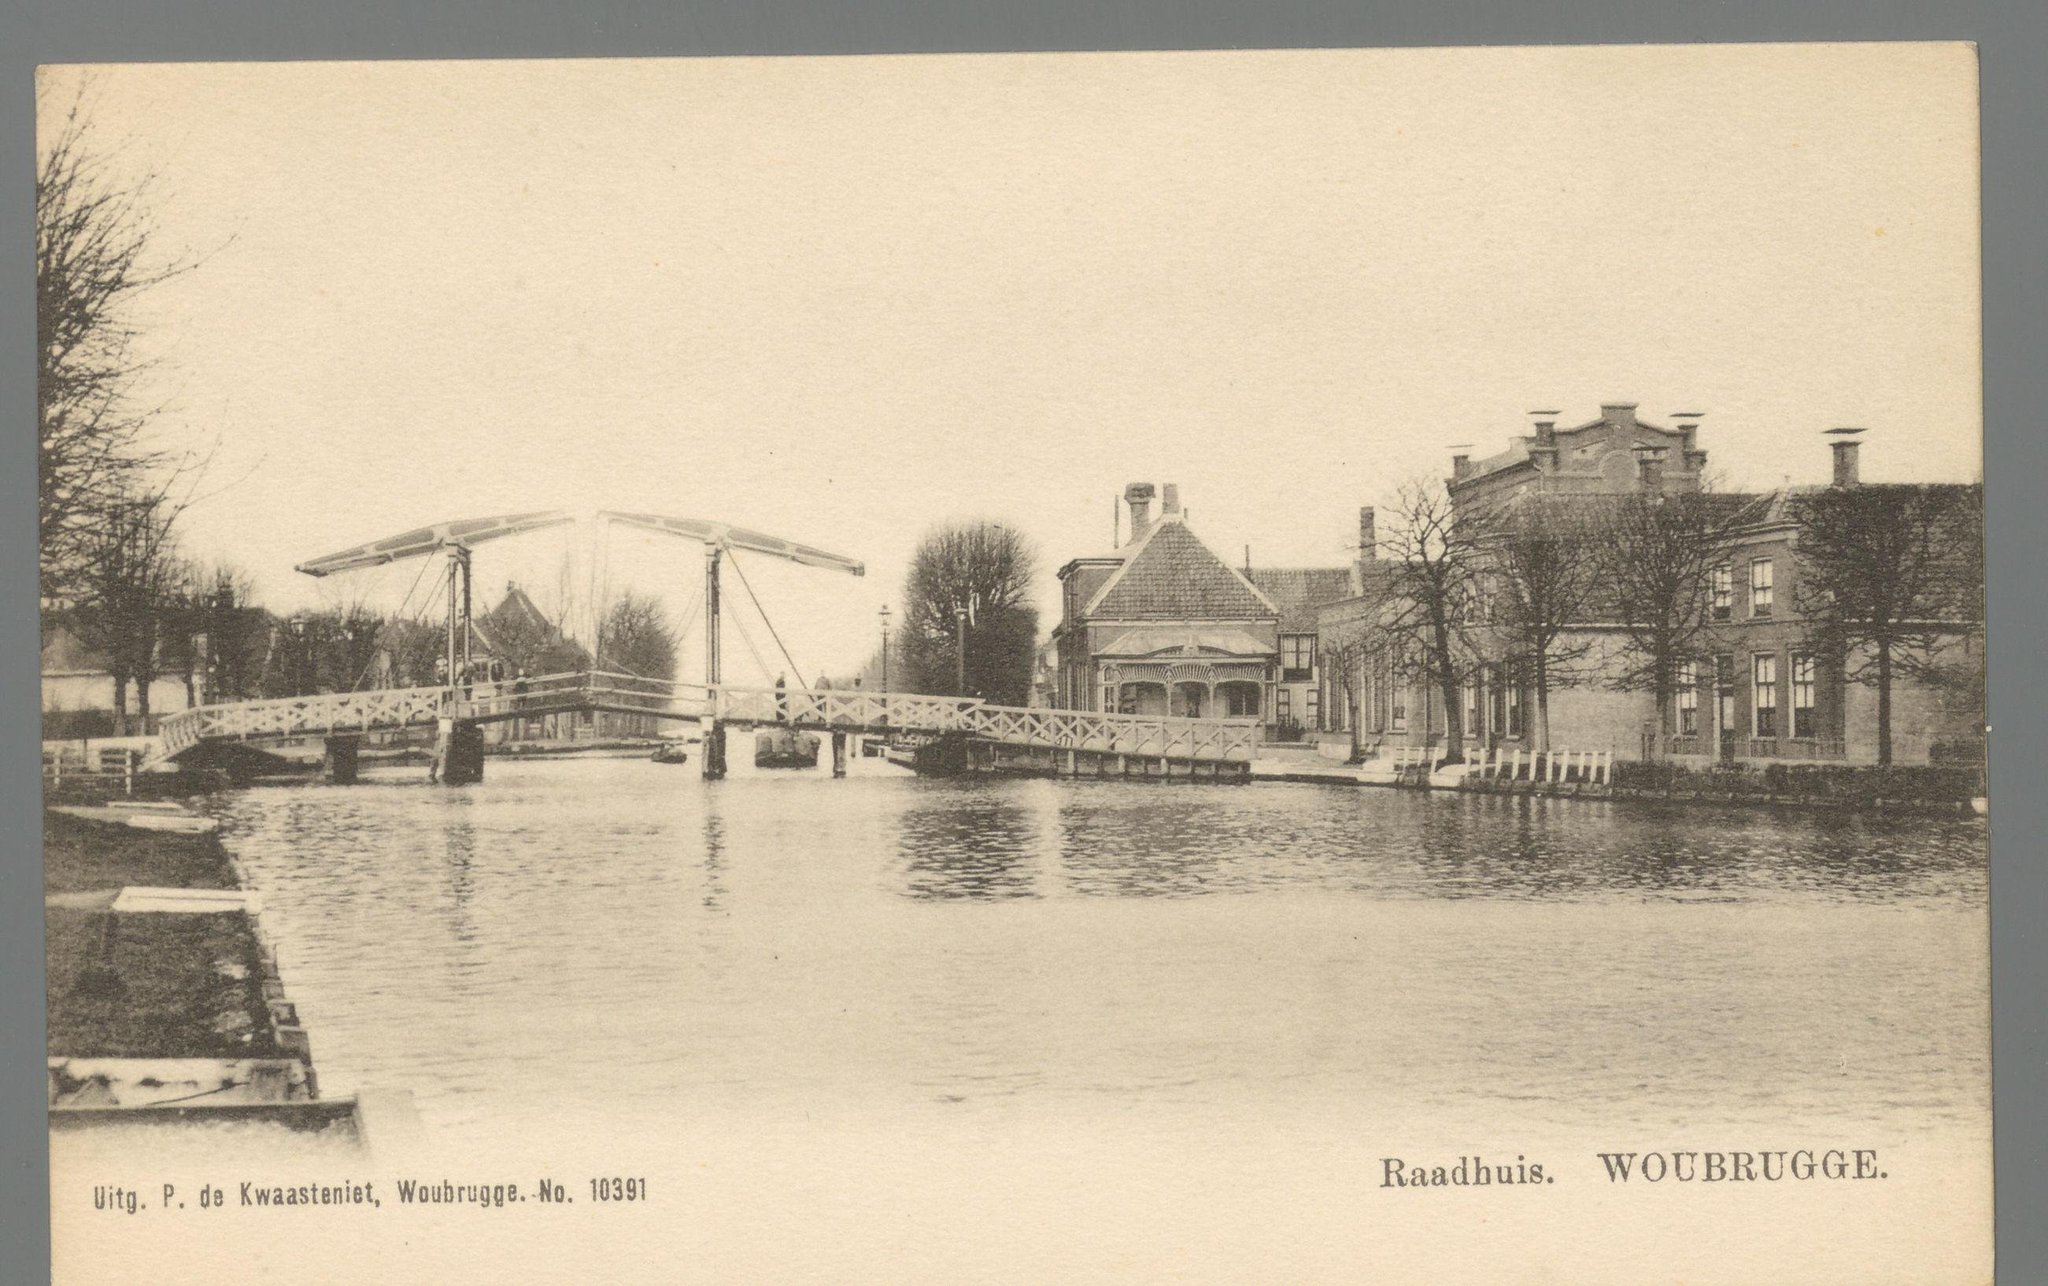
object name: photomechanical print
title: Raadhuis. Woubrugge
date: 1897-1905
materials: cardboard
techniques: photograph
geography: woubrugge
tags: canals, waters (in village), townhall, street, bridge in village across river, canal, etc.